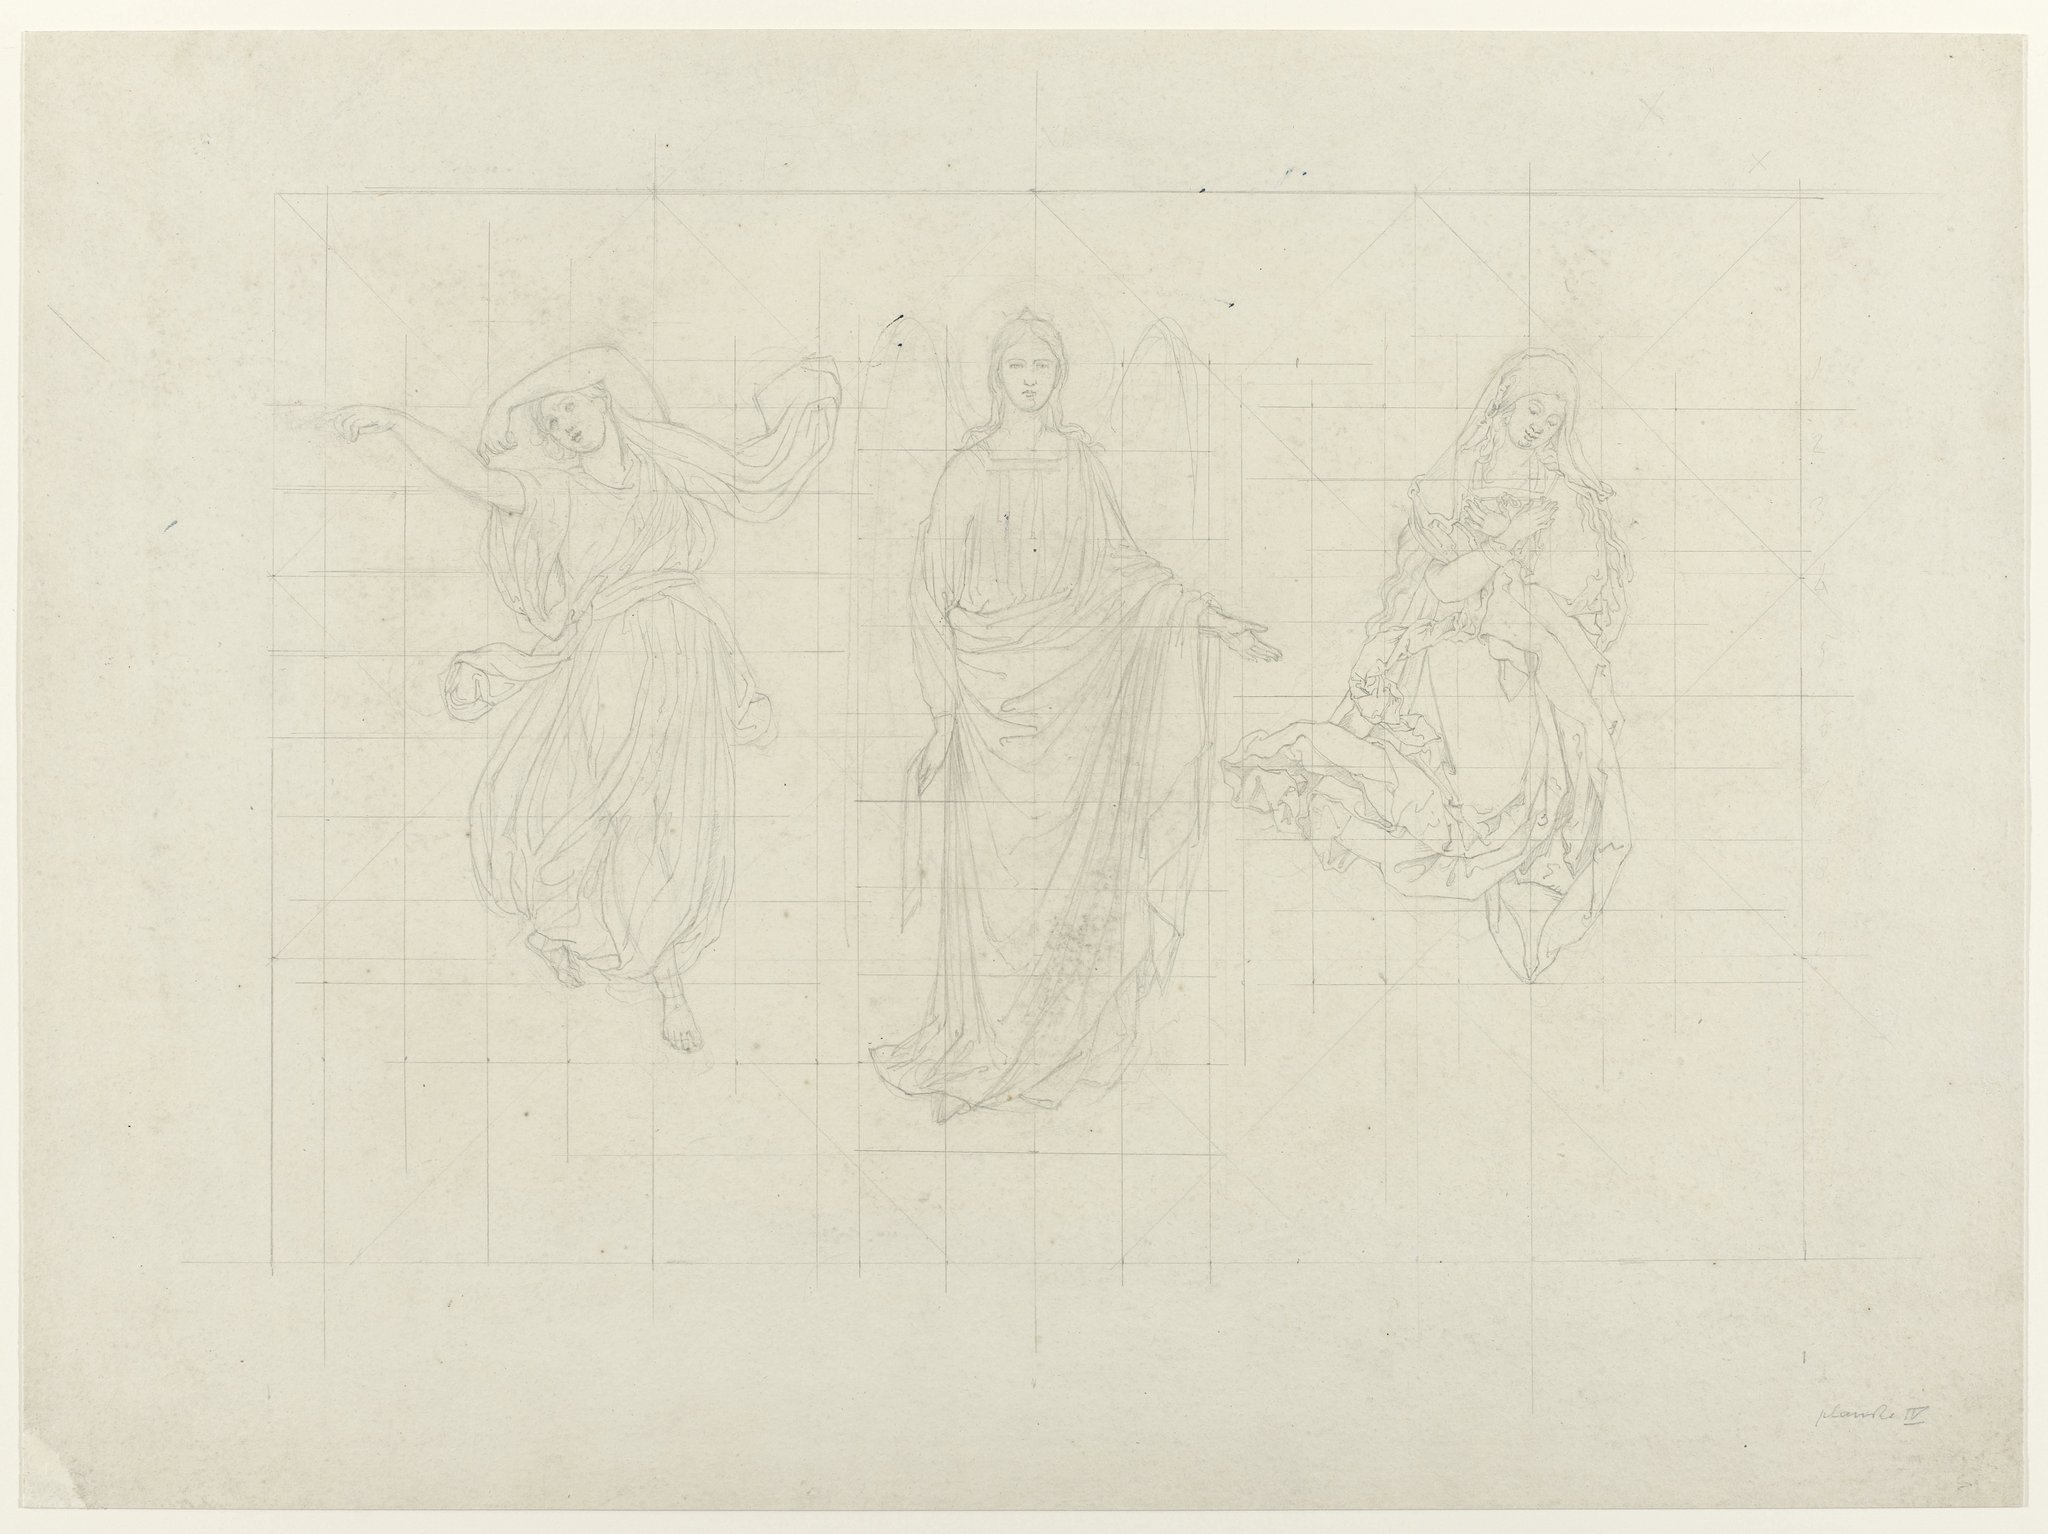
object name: drawing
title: Drie vrouwelijke figuren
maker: david pièrre giottino humbert de superville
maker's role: draughtsman, painter, print maker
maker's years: 1770-1849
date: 1780-1849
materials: paper, pencil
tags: dancing, lower angel(s), mary (alone) reading, praying, etc. ~ annunciation